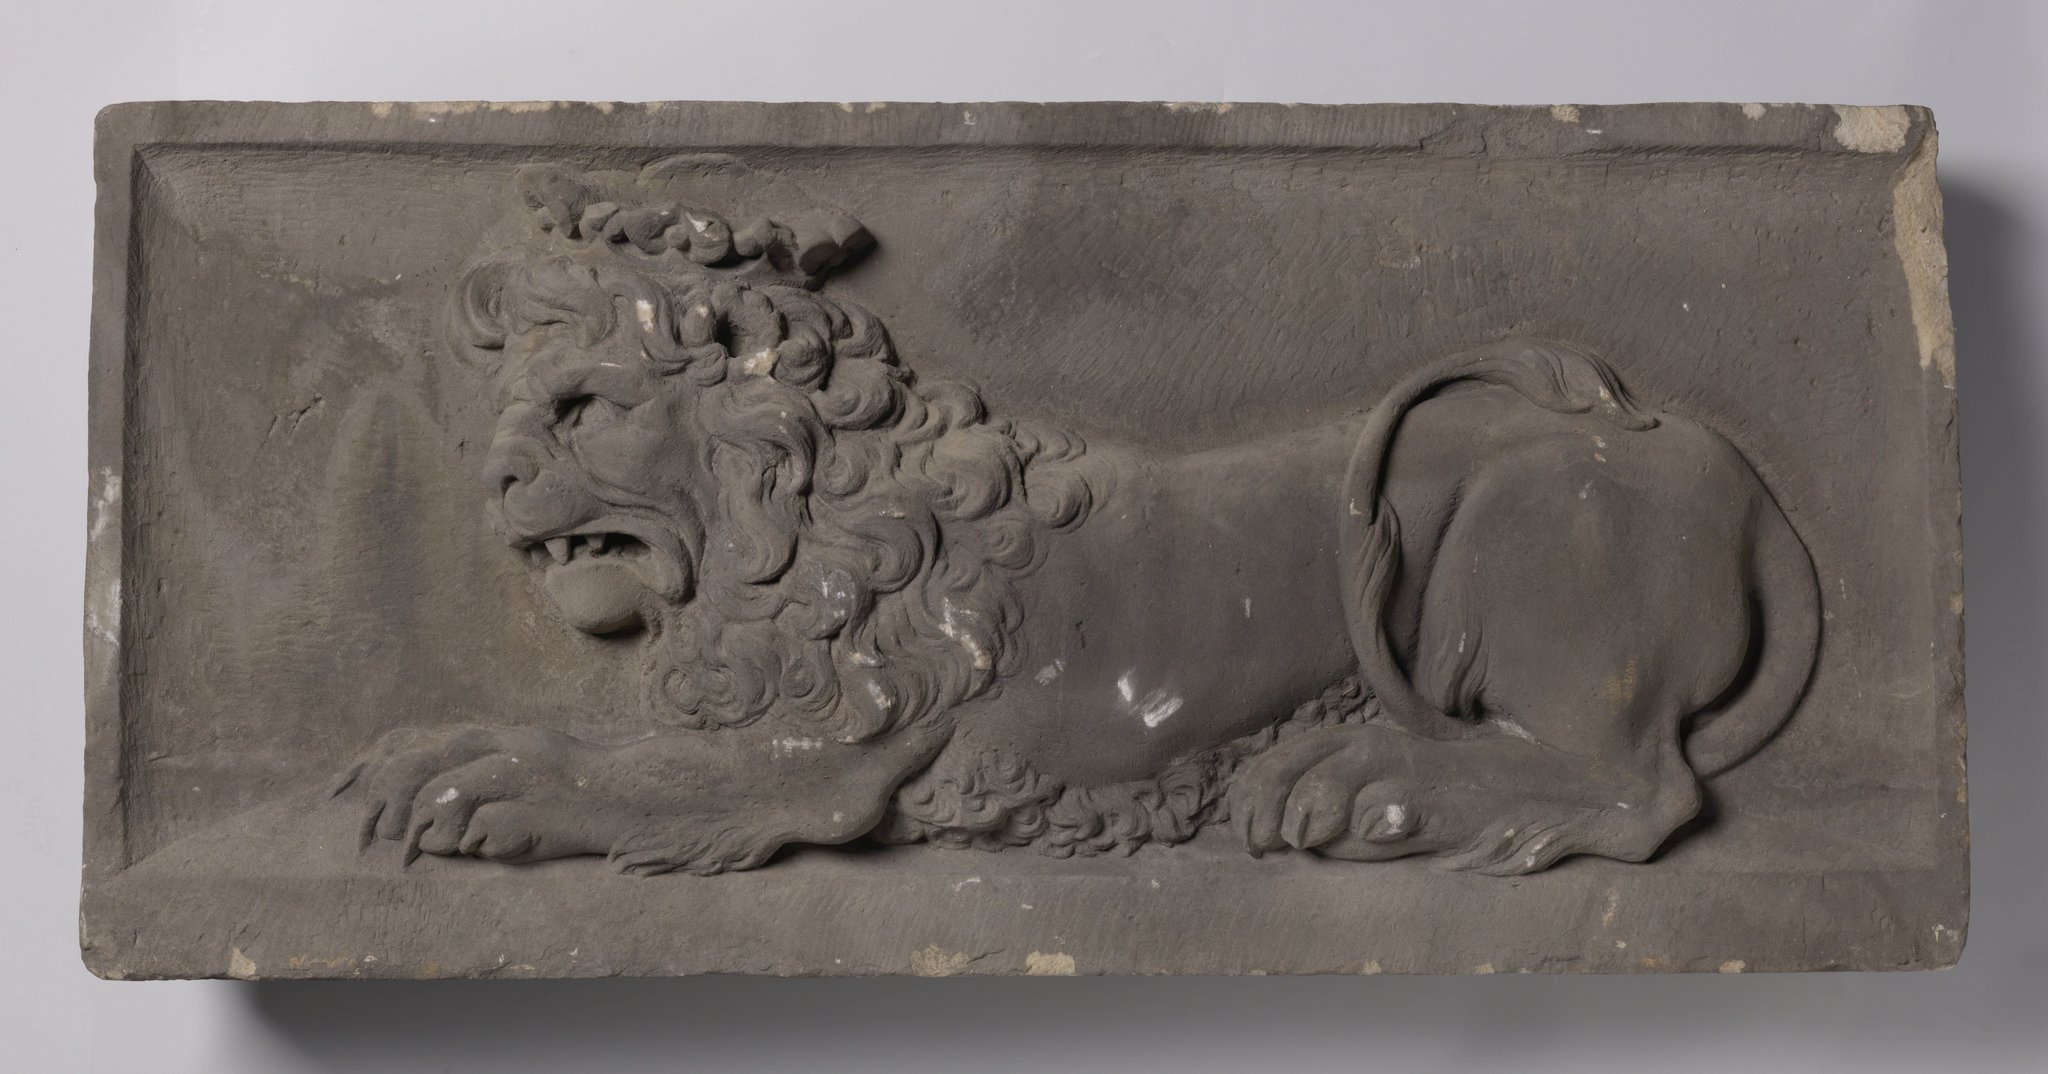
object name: gable stone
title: Gevelsteen met naar links gewende liggende gekroonde leeuw.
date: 1663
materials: stone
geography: netherlands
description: Liggende rechthoek waarop een naar links gewende liggende, gekroonde leeuw. Bij de steen horen twee gevelstenen: KOG-ALS-147-2 met ANNO en KOG-ALS-147-3 met 1663.